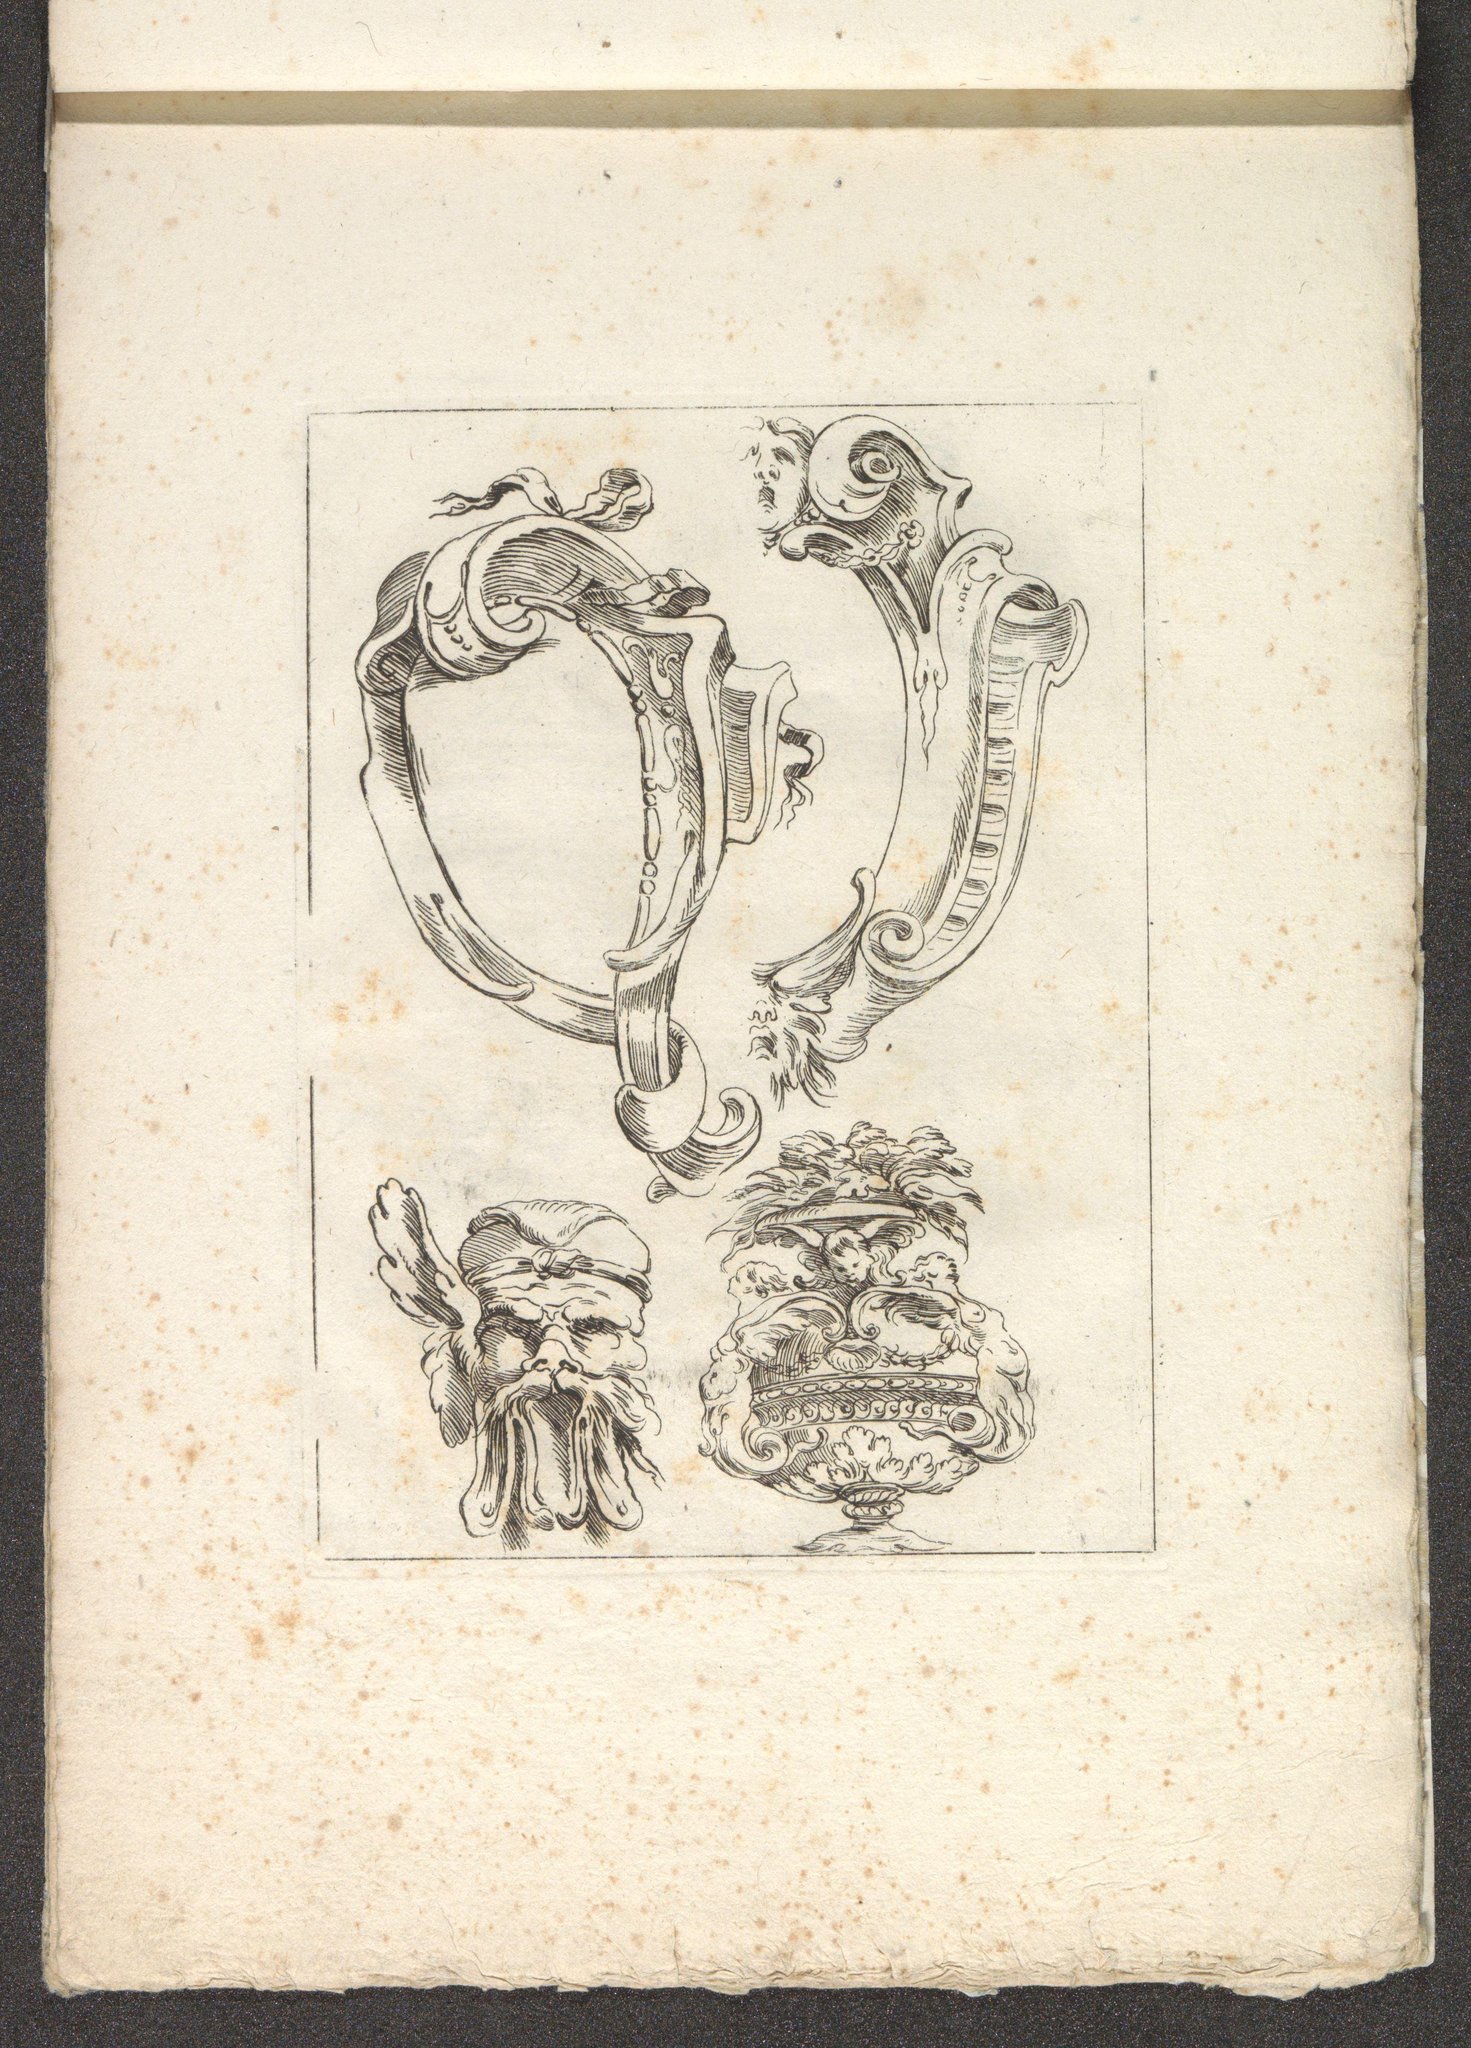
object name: album leaf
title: Disegni, et Abbozzi di Agostino Mitelli Intagliati Dal Figluolo di Lui Gioseppe Maria Mitelli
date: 1644-1718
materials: paper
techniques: etching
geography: bologna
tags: ornaments ~ art, vase ~ ornament, ornament ~ cartouche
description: Boven een hele en een halve cartouche. Onder een ornamentkop en een ornamentele vaas. De prent maakt deel uit van een album.